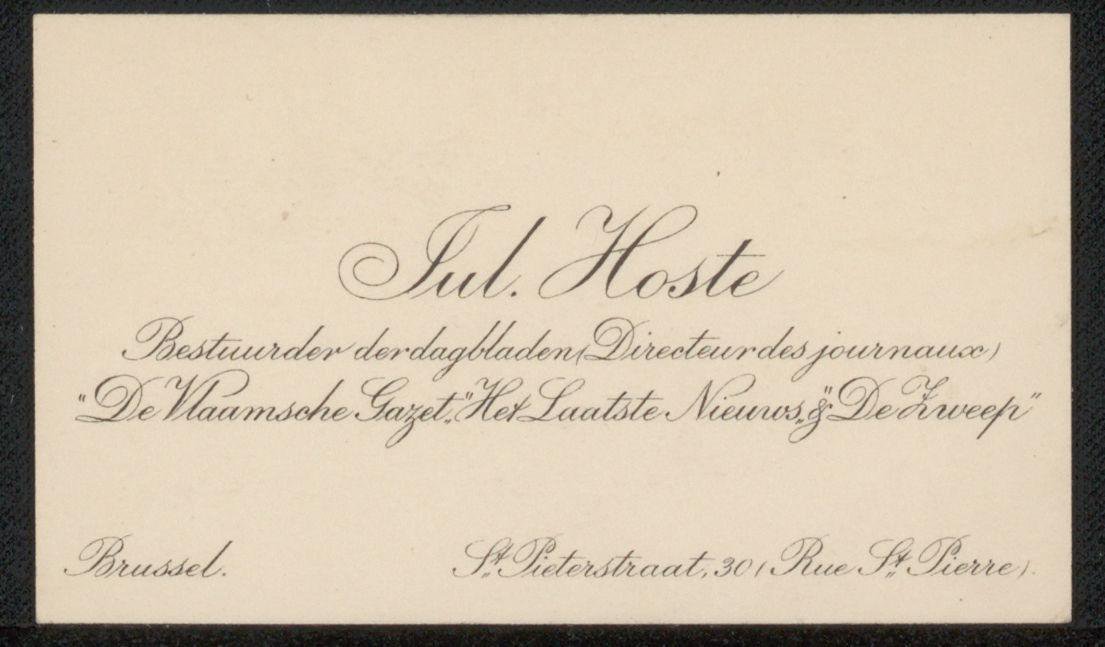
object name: visiting card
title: Visitekaartje aan Philip Zilcken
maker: julius hoste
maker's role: auteur, hoofdredacteur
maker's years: 1848-1933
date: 1858-1933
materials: cardboard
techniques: printing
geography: brussels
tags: the hague, painter, draughtsman, philip zilcken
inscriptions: collector's mark: ‘RPK’